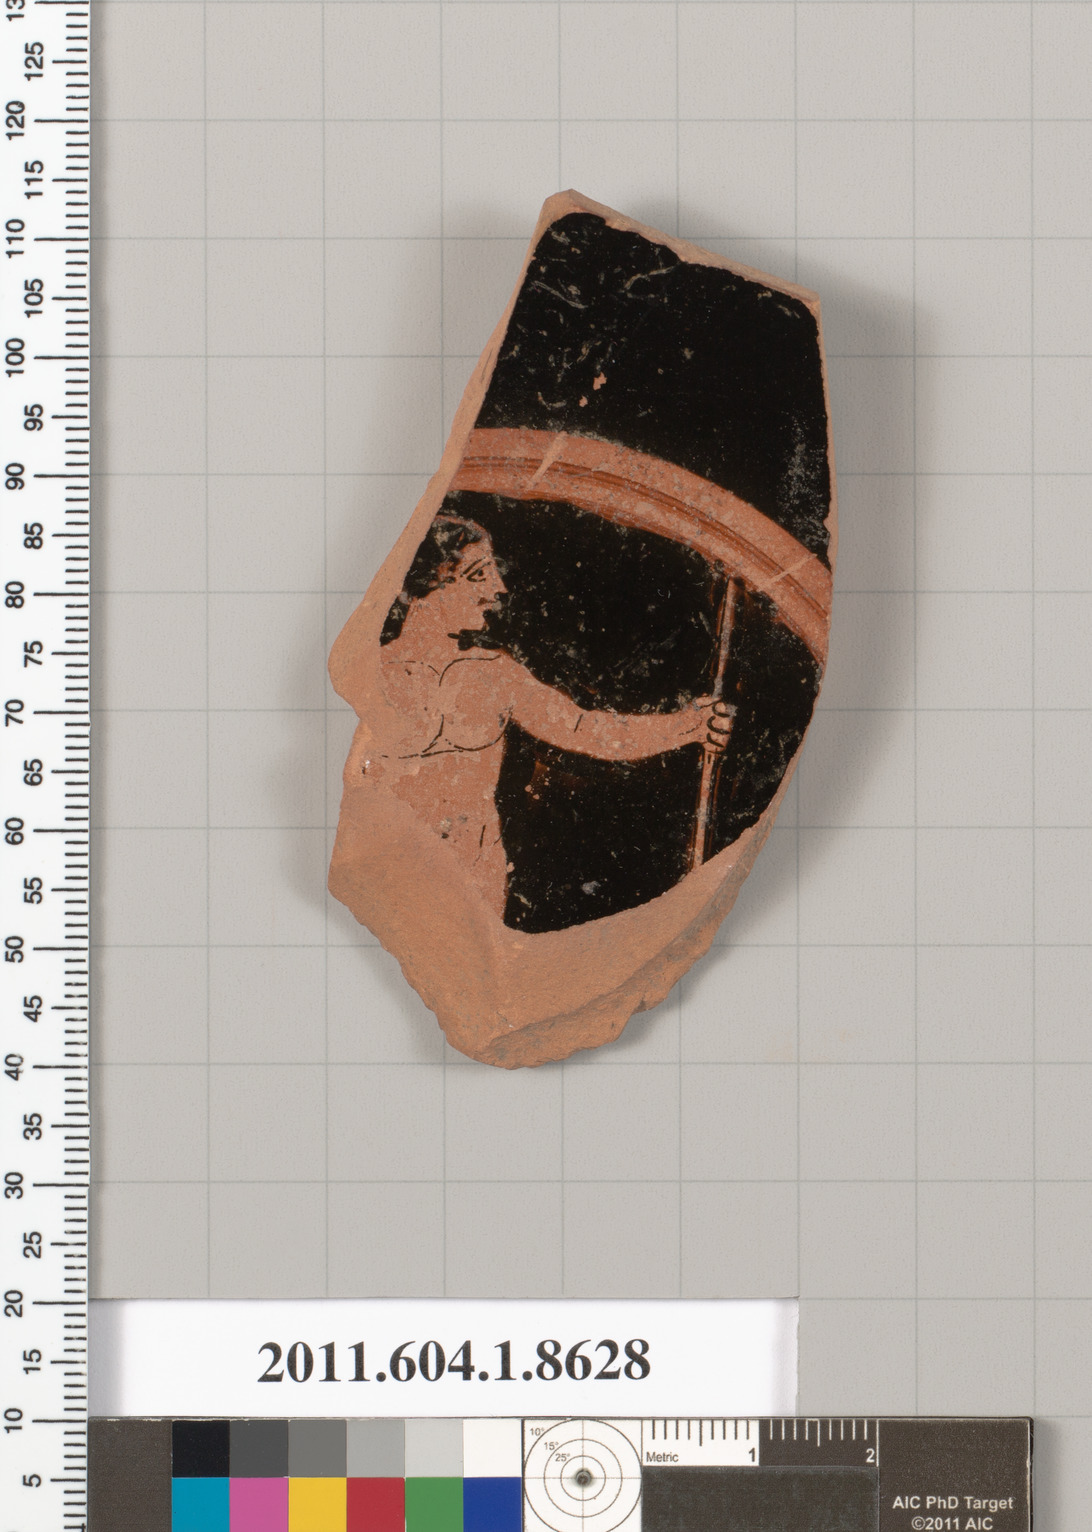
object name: kylix fragment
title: Terracotta fragment of a stemless kylix (drinking cup)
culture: greek, attic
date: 467-435 BCE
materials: terracotta